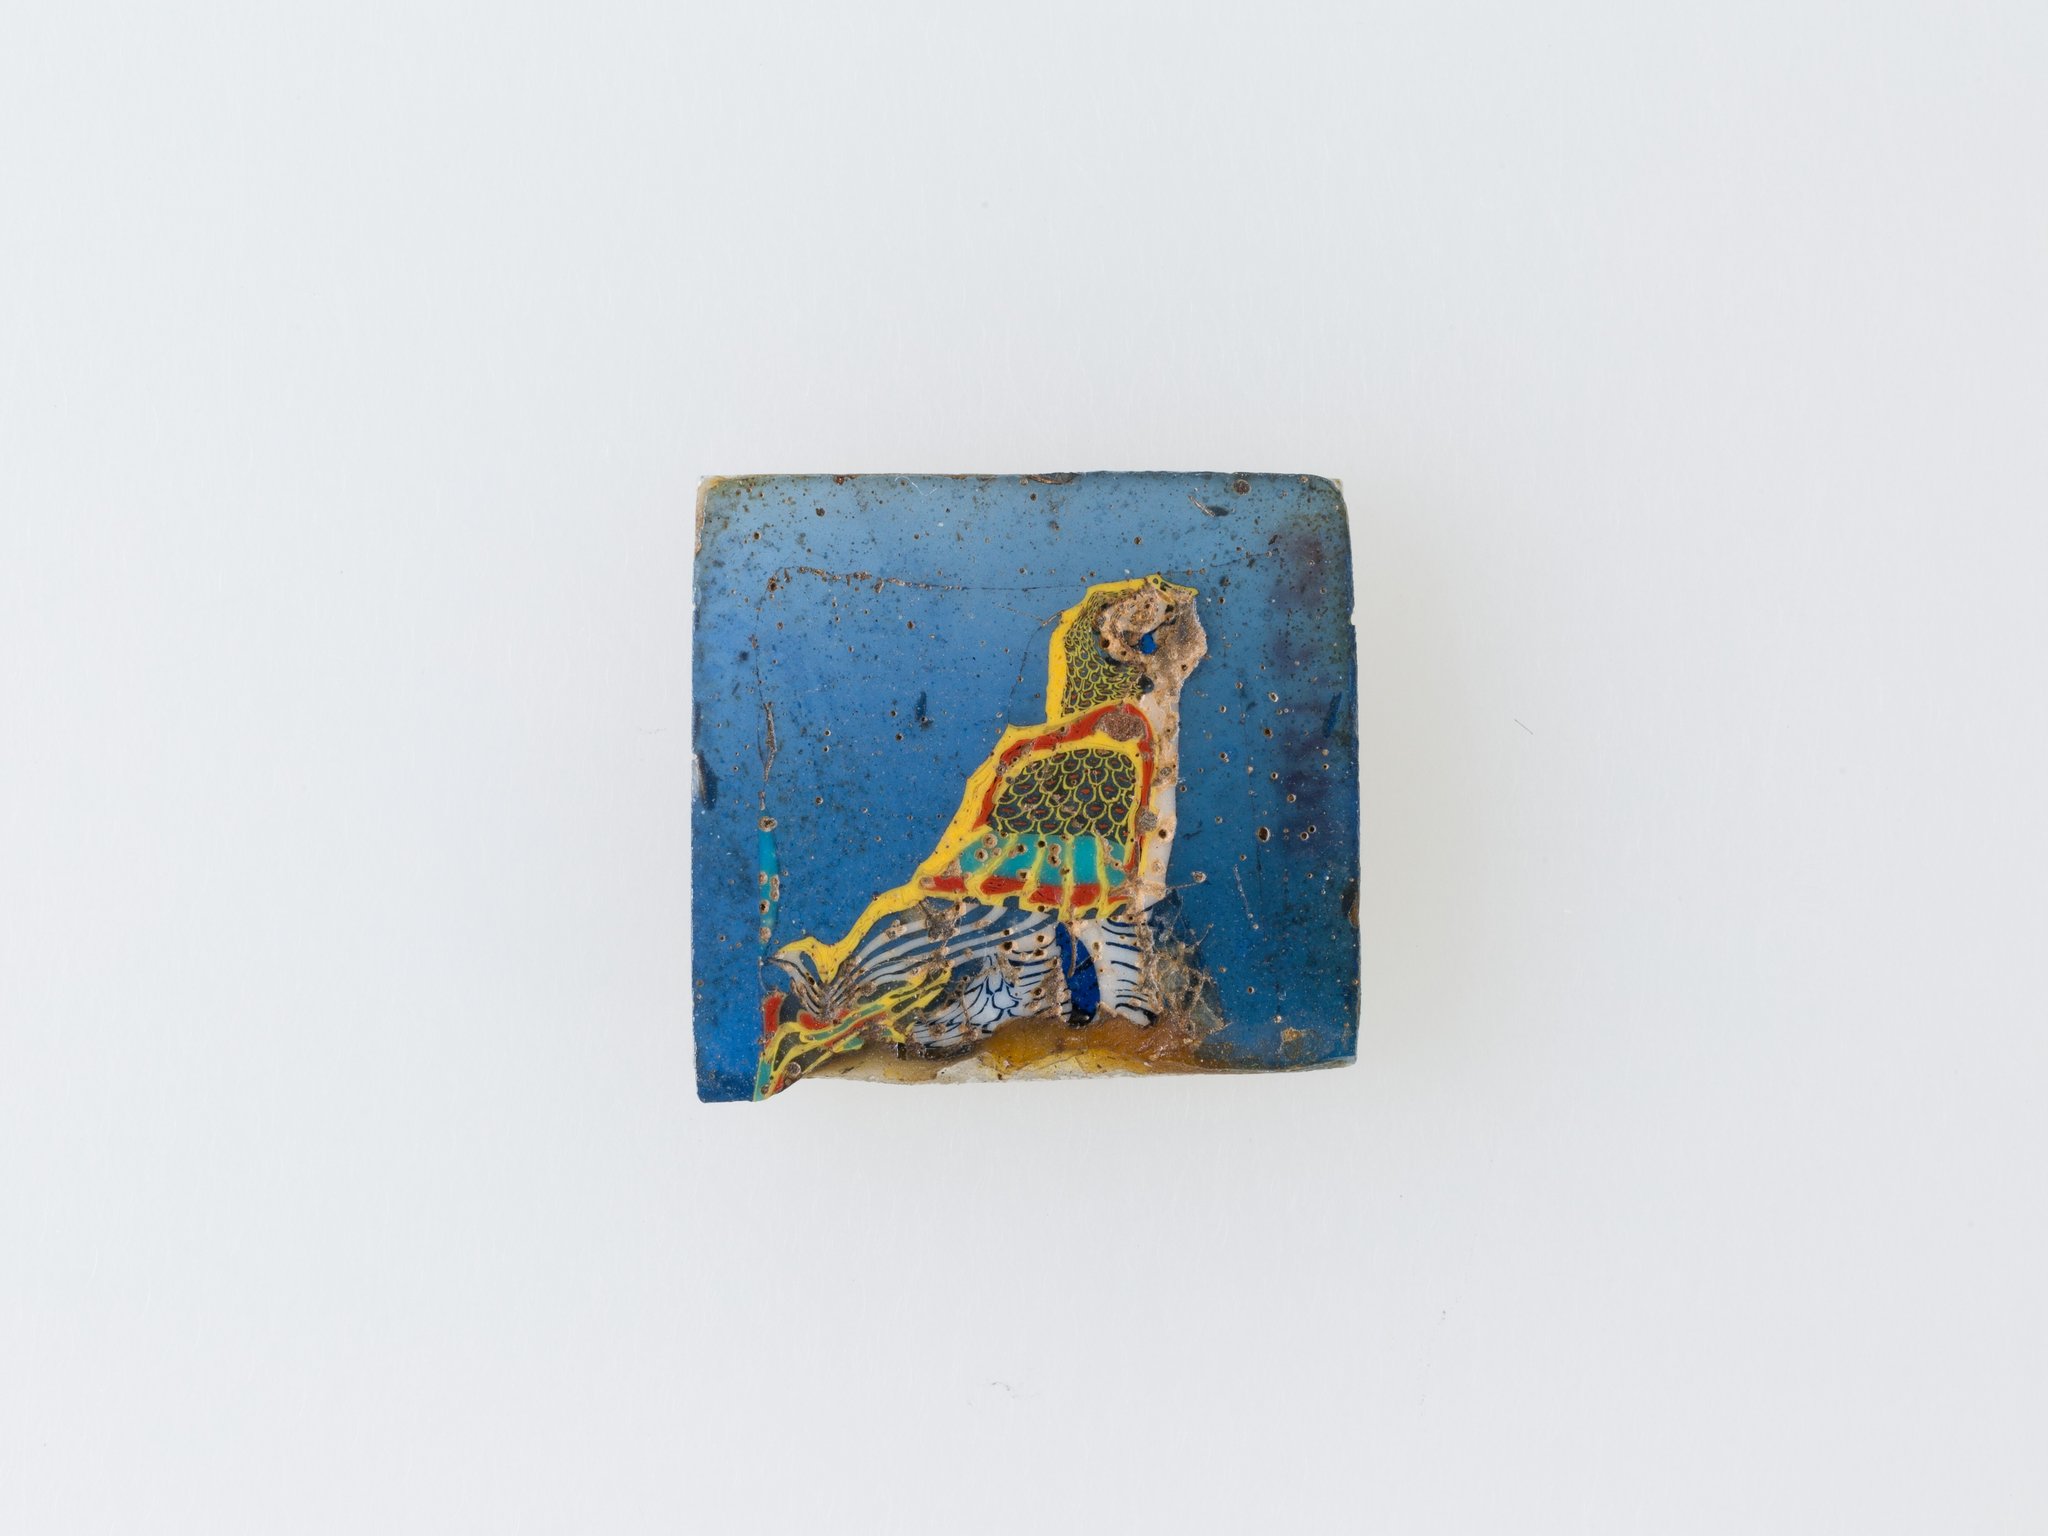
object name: inlay, falcon, hieroglyph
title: Inlay, falcon hieroglyph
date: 100 BCE-100 CE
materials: glass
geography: egypt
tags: falcons